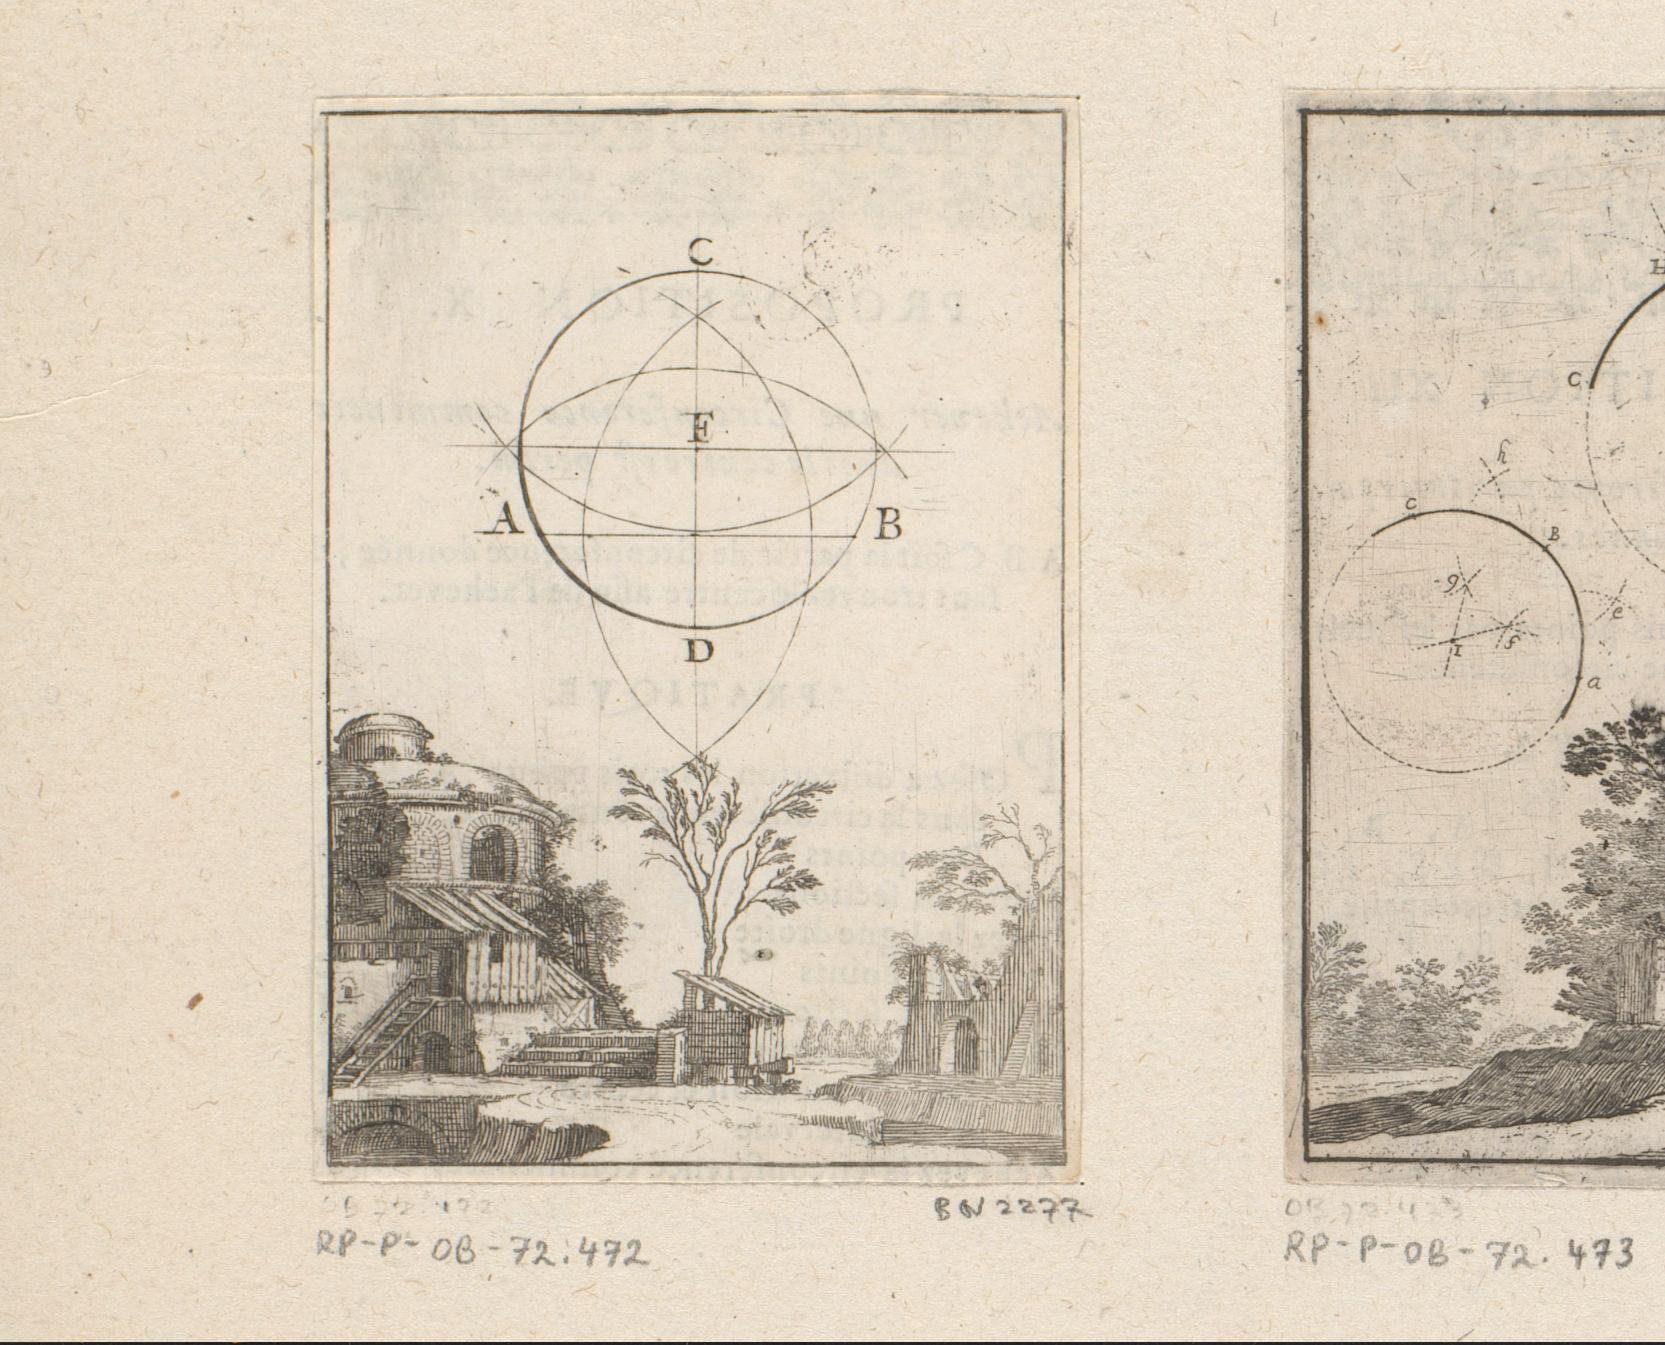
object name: print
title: Vinden van het middelpunt van een gegeven cirkel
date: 1669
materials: paper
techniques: etching, letterpress printing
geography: france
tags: city-view, and landscape with man-made constructions, planimetry, geometry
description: Prent uit: Pratique de la géometrie, sur le papier et sur le terrain. Avec un nouvel ordre et une méthode particulière. Parijs: Thomas Jolly, 1669.